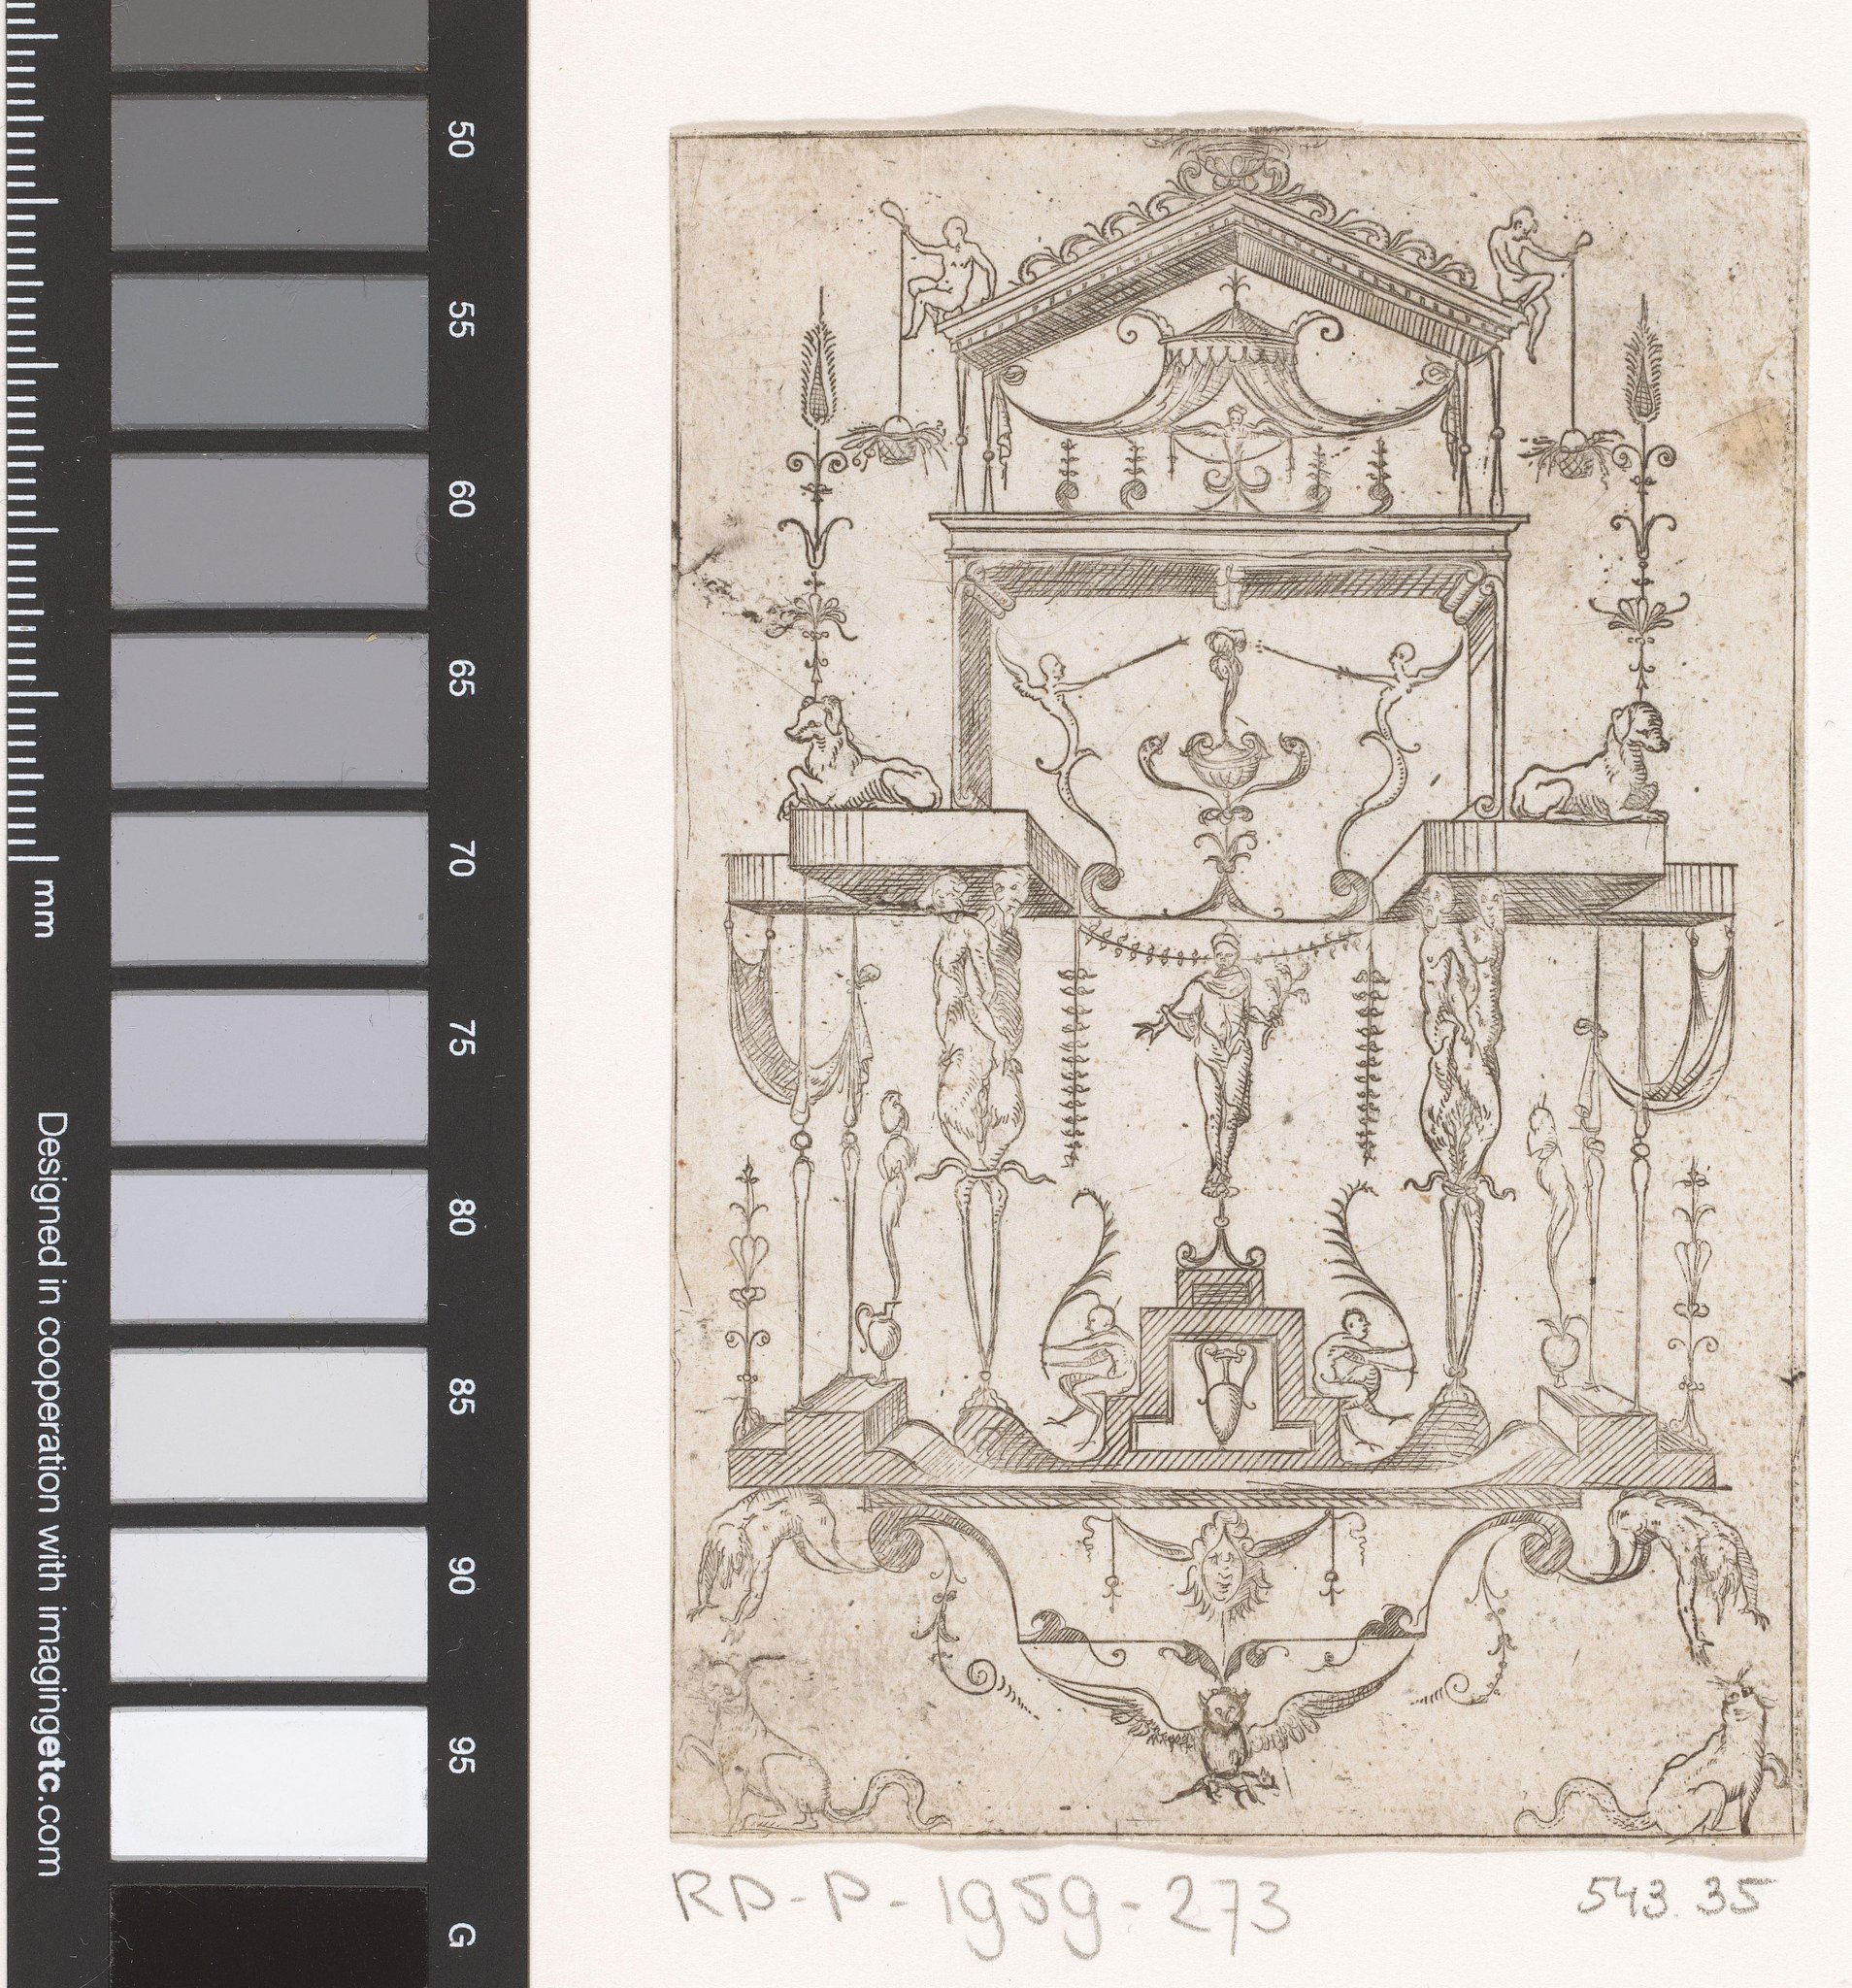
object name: ornament print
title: Vlakdecoraties, architectuurfantasieën en grotesken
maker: Anonymous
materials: paper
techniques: etching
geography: paris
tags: frequently used ornamental compositions, fantastic architecture, unrealistic architectural fantasies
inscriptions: collector's mark: Lugt 2228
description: Een decoratieve compositie met een fantasie-bouwwerk. Onderaan wordt het bouwwerk gesteund door twee dubbele thermen in de vorm van saters met aan elkaar gebonden benen. In het bouwwerk staat een figuur met een tak in de hand op een voetstuk.